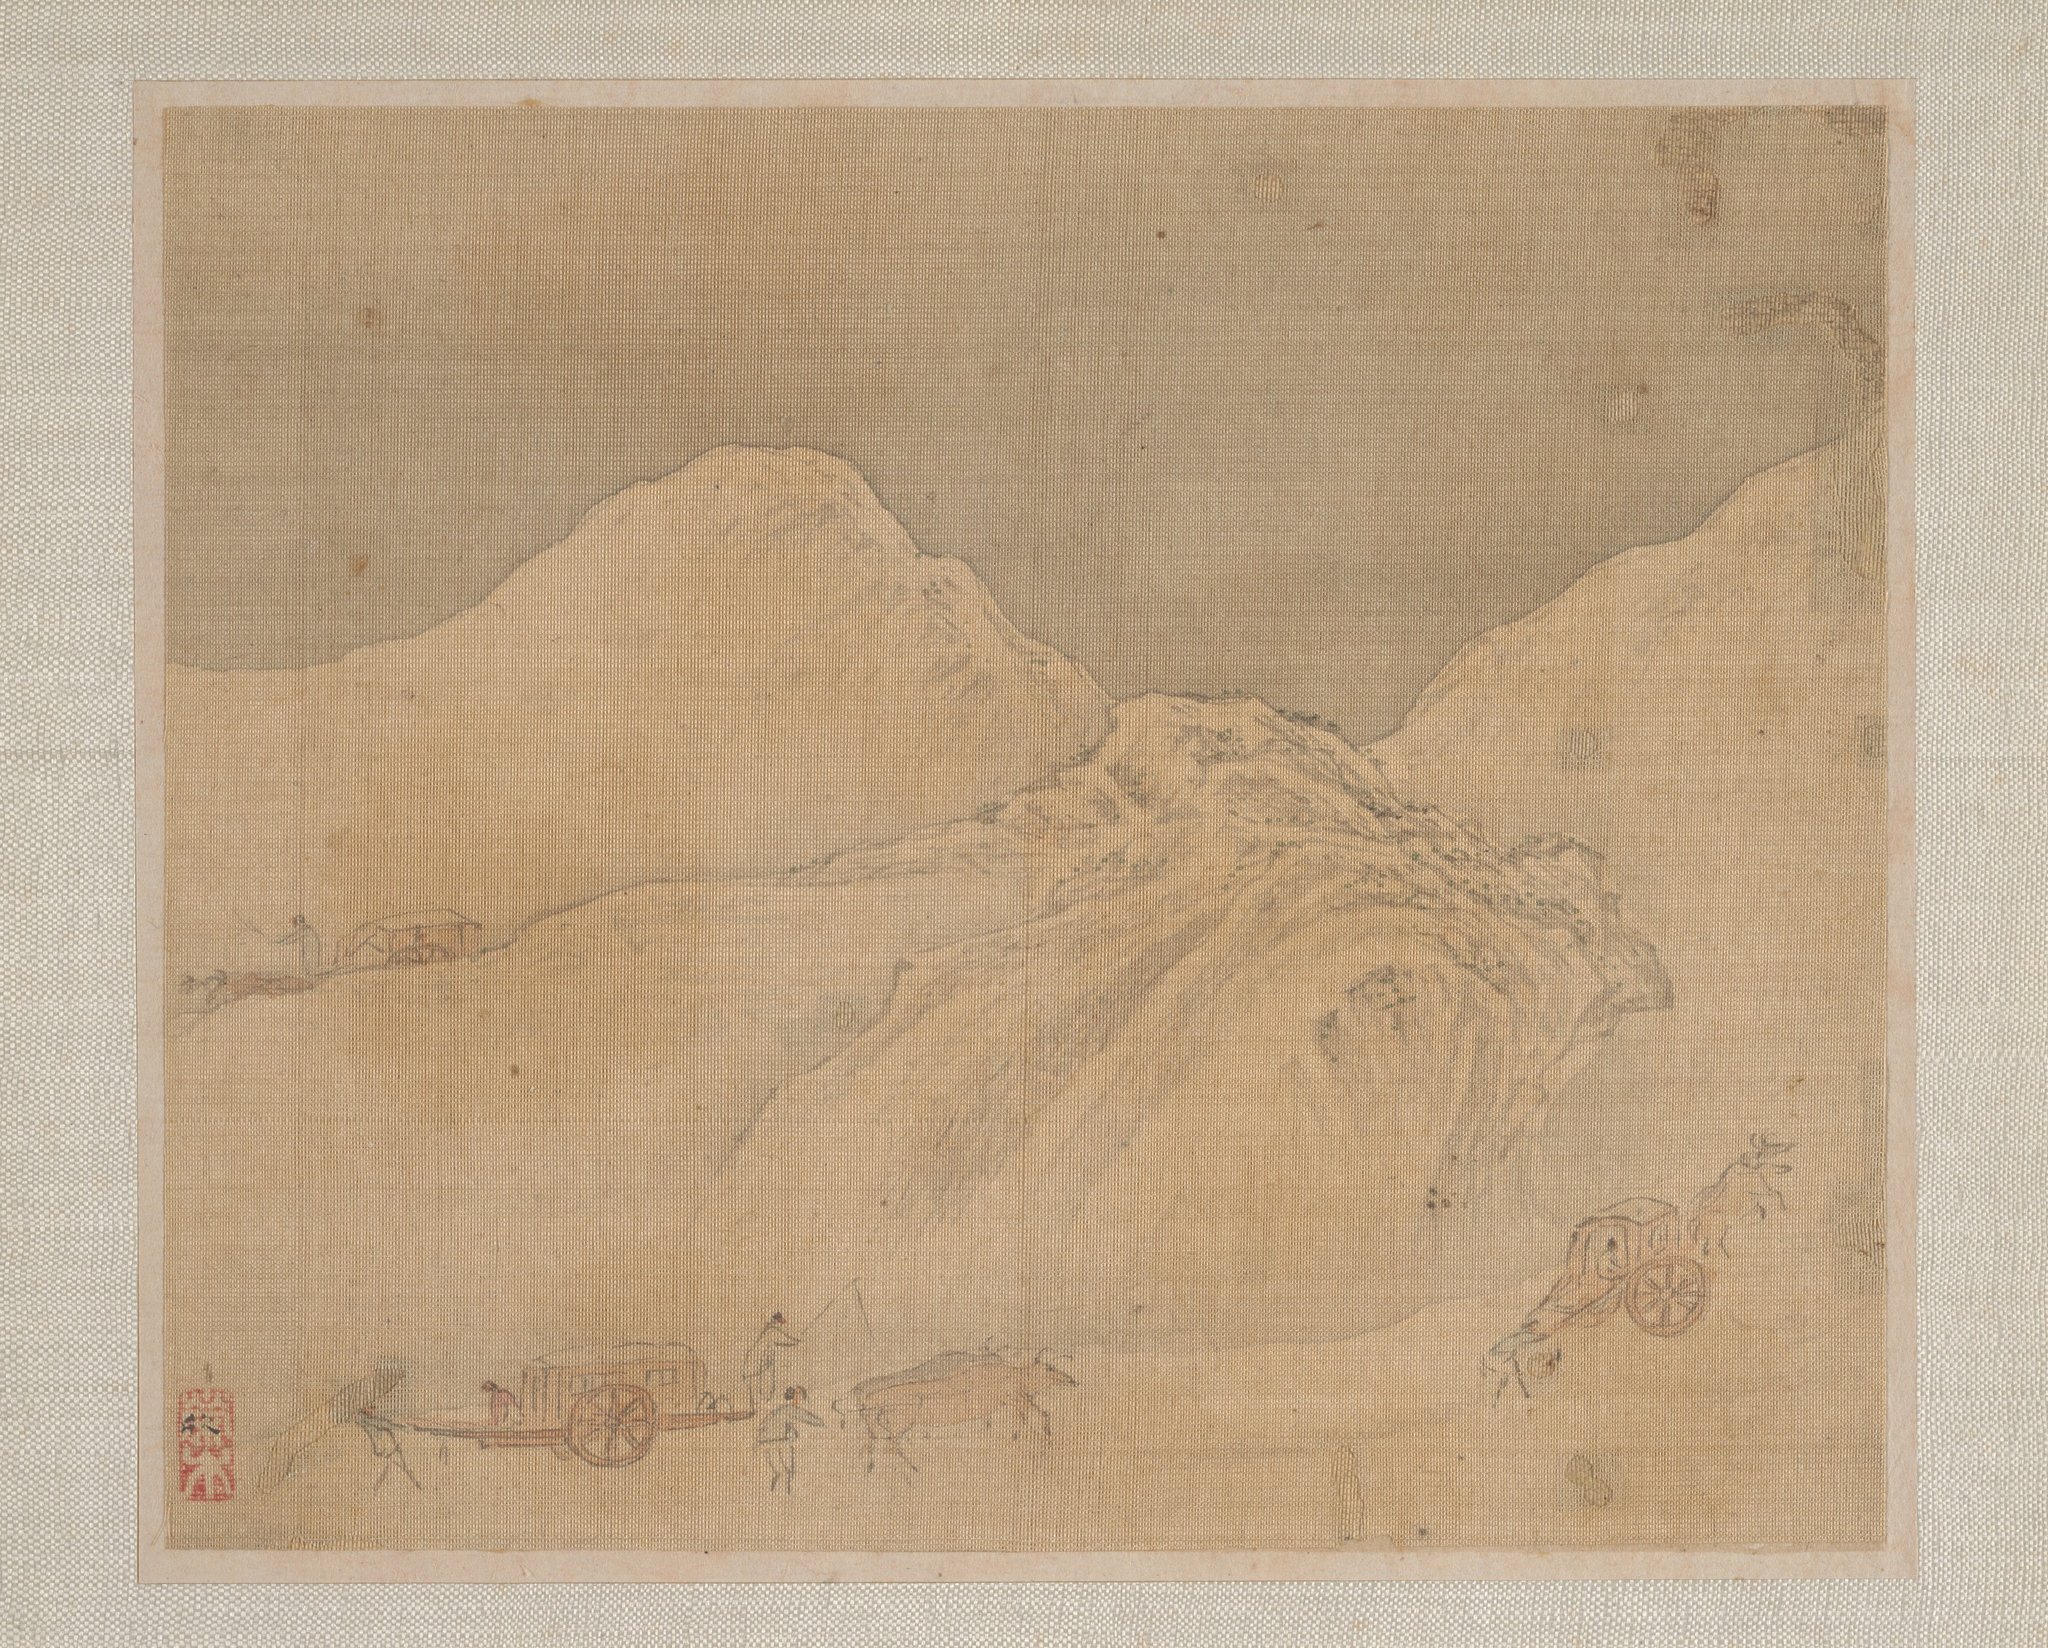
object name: album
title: Landscapes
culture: chinese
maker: ye xin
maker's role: artist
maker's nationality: chinese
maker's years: 1640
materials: ink, silk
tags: landscapes,carts,ox